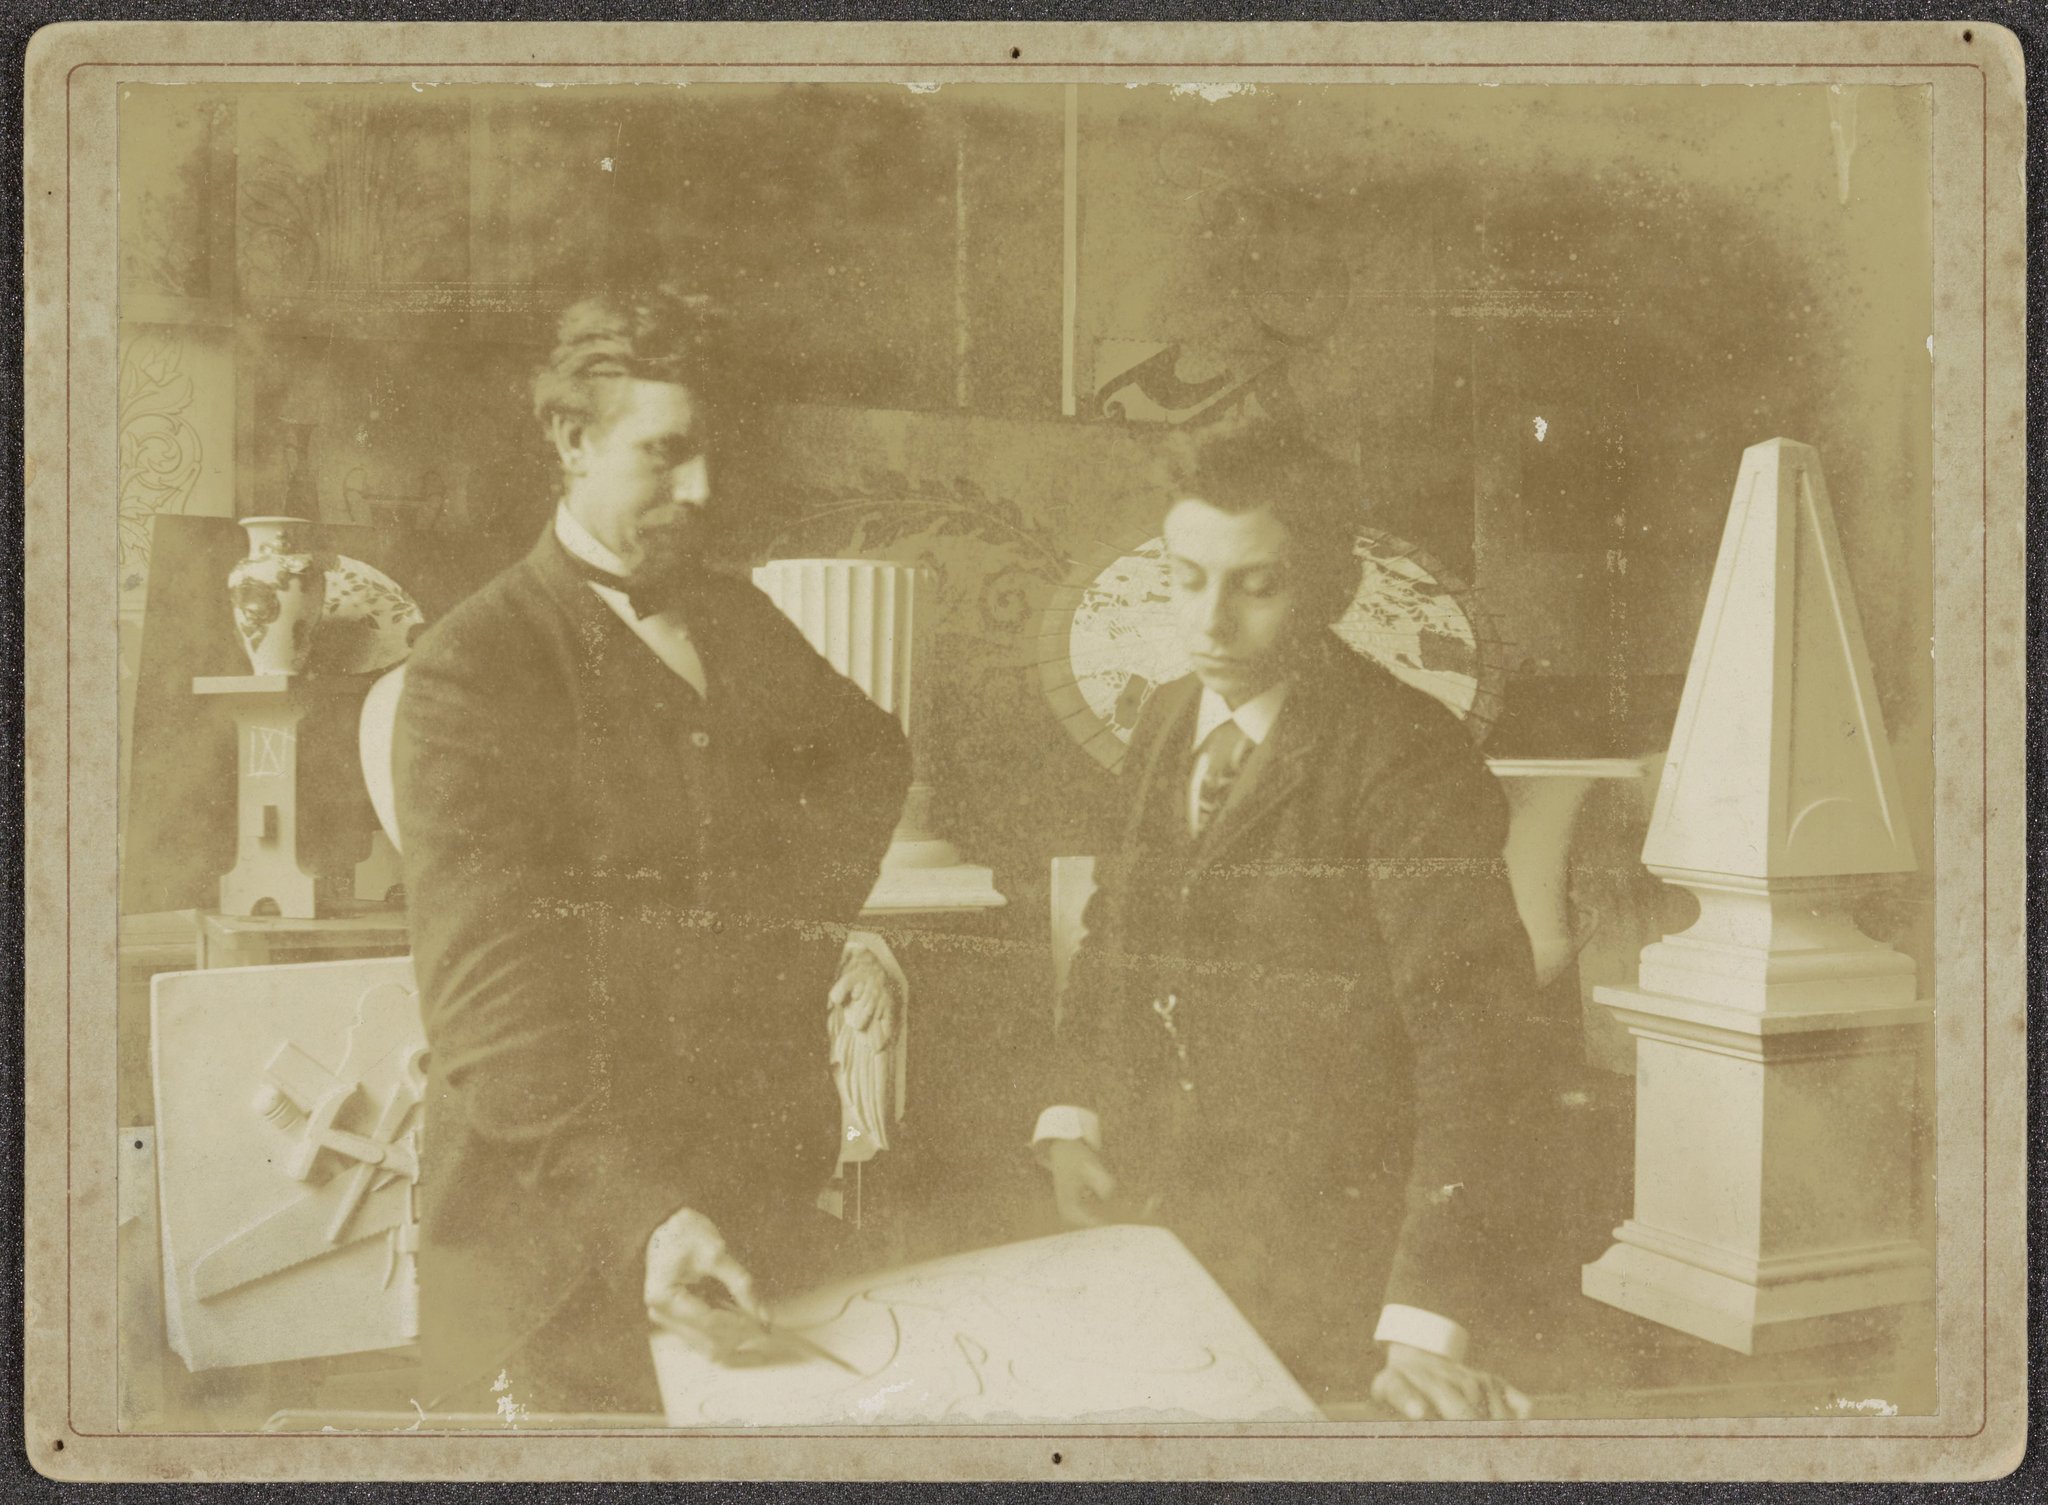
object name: photograph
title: Hendrik van Roggen krijgt les van leraar Steenbeek op de Rijksnormaalschool in het Rijksmuseum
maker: Anonymous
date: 1891-1894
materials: cardboard, photographic support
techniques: gelatin silver print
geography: amsterdam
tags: education, tuition of the artist (in general)